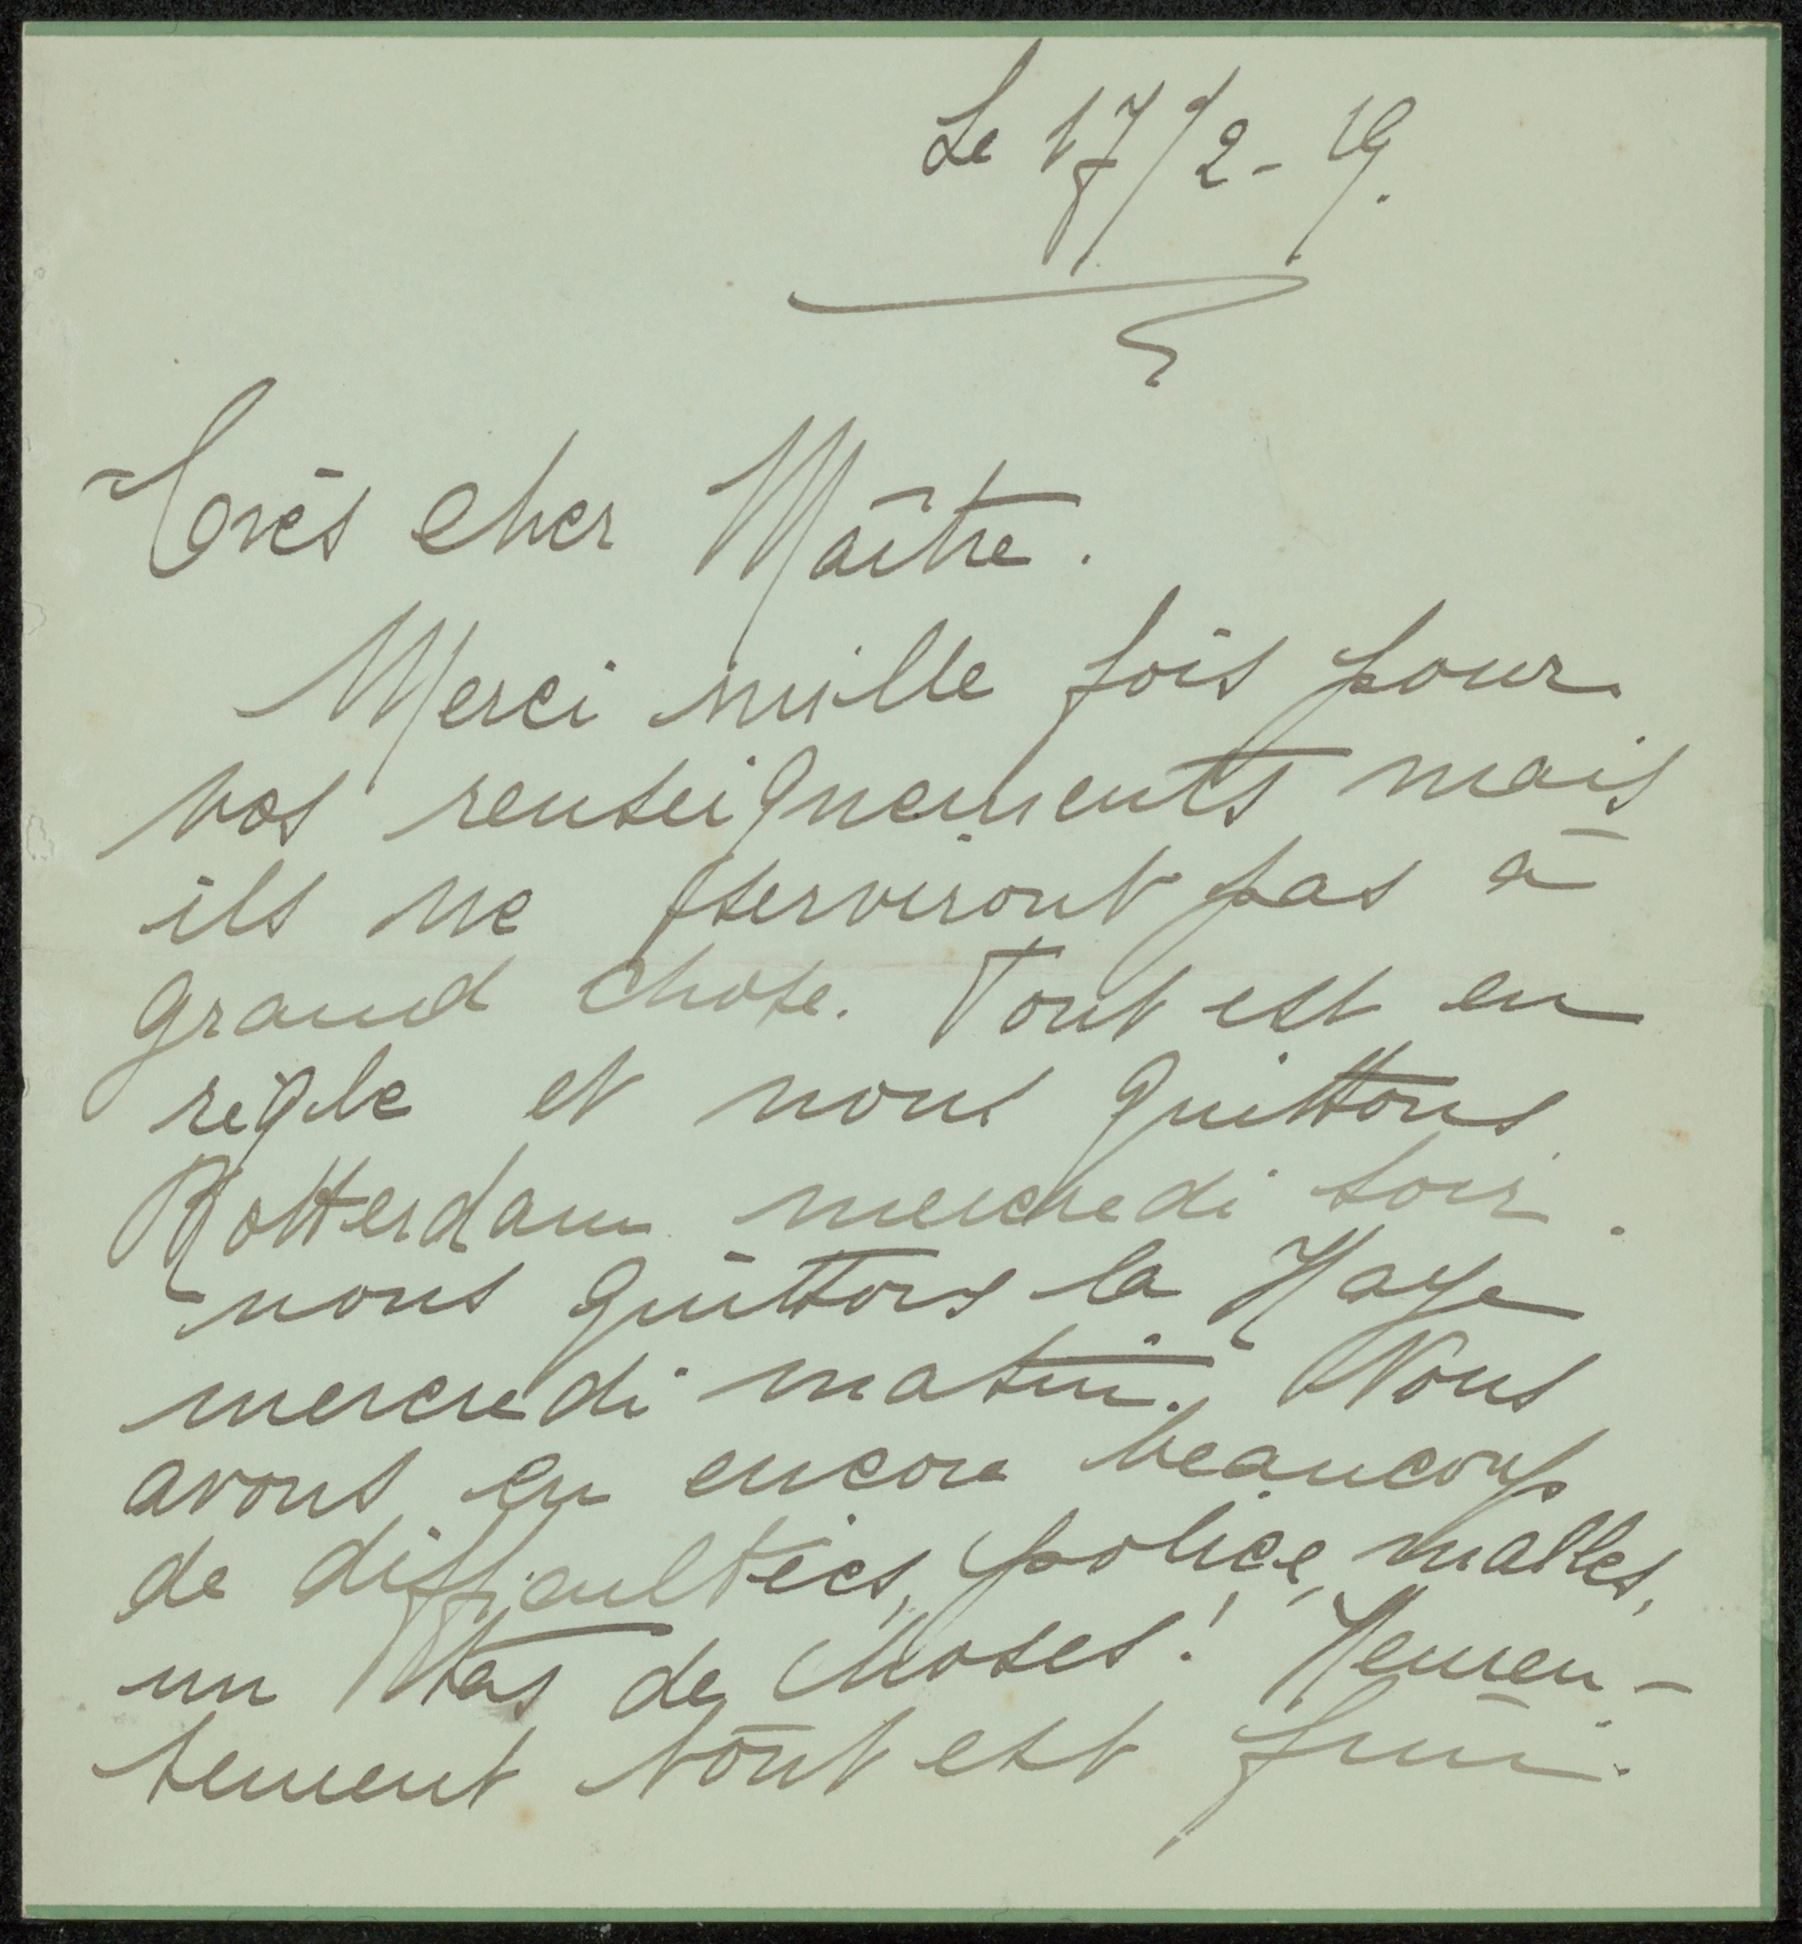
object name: letter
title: Brief aan Philip Zilcken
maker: rose imel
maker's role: draughtsman, painter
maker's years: 1901-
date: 1919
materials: ink, paper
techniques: pen, writing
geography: scheveningen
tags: painter, draughtsman, philip zilcken, the hague, rotterdam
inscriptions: collector's mark: ‘RPK’